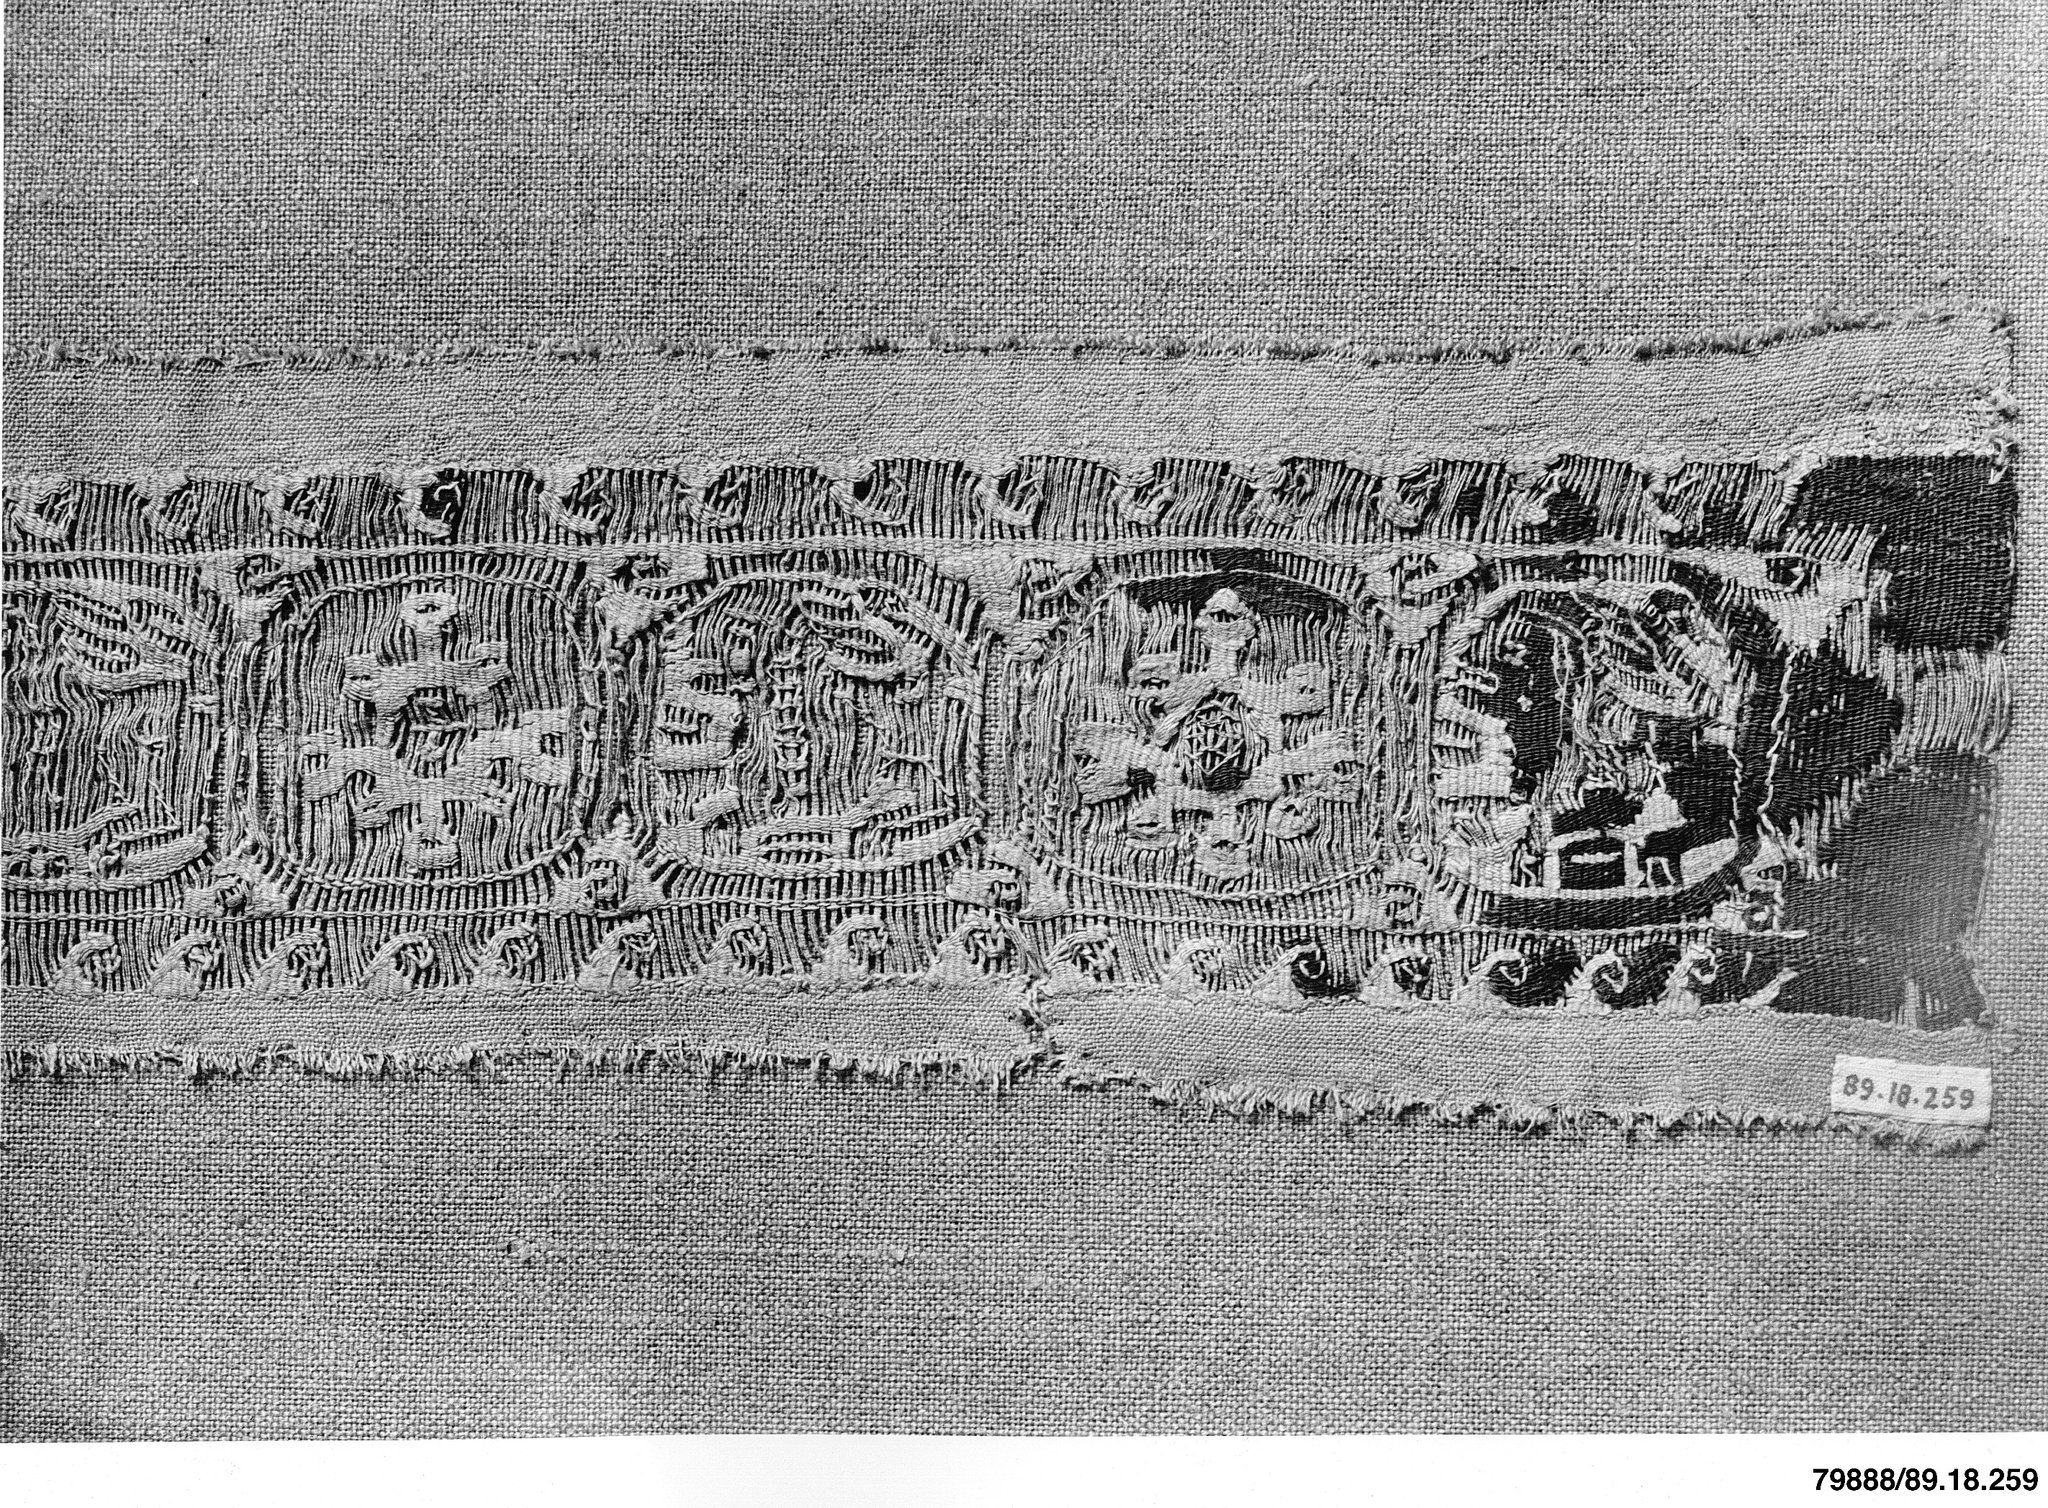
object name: textile fragment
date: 201-400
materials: linen, wool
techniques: weave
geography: egypt